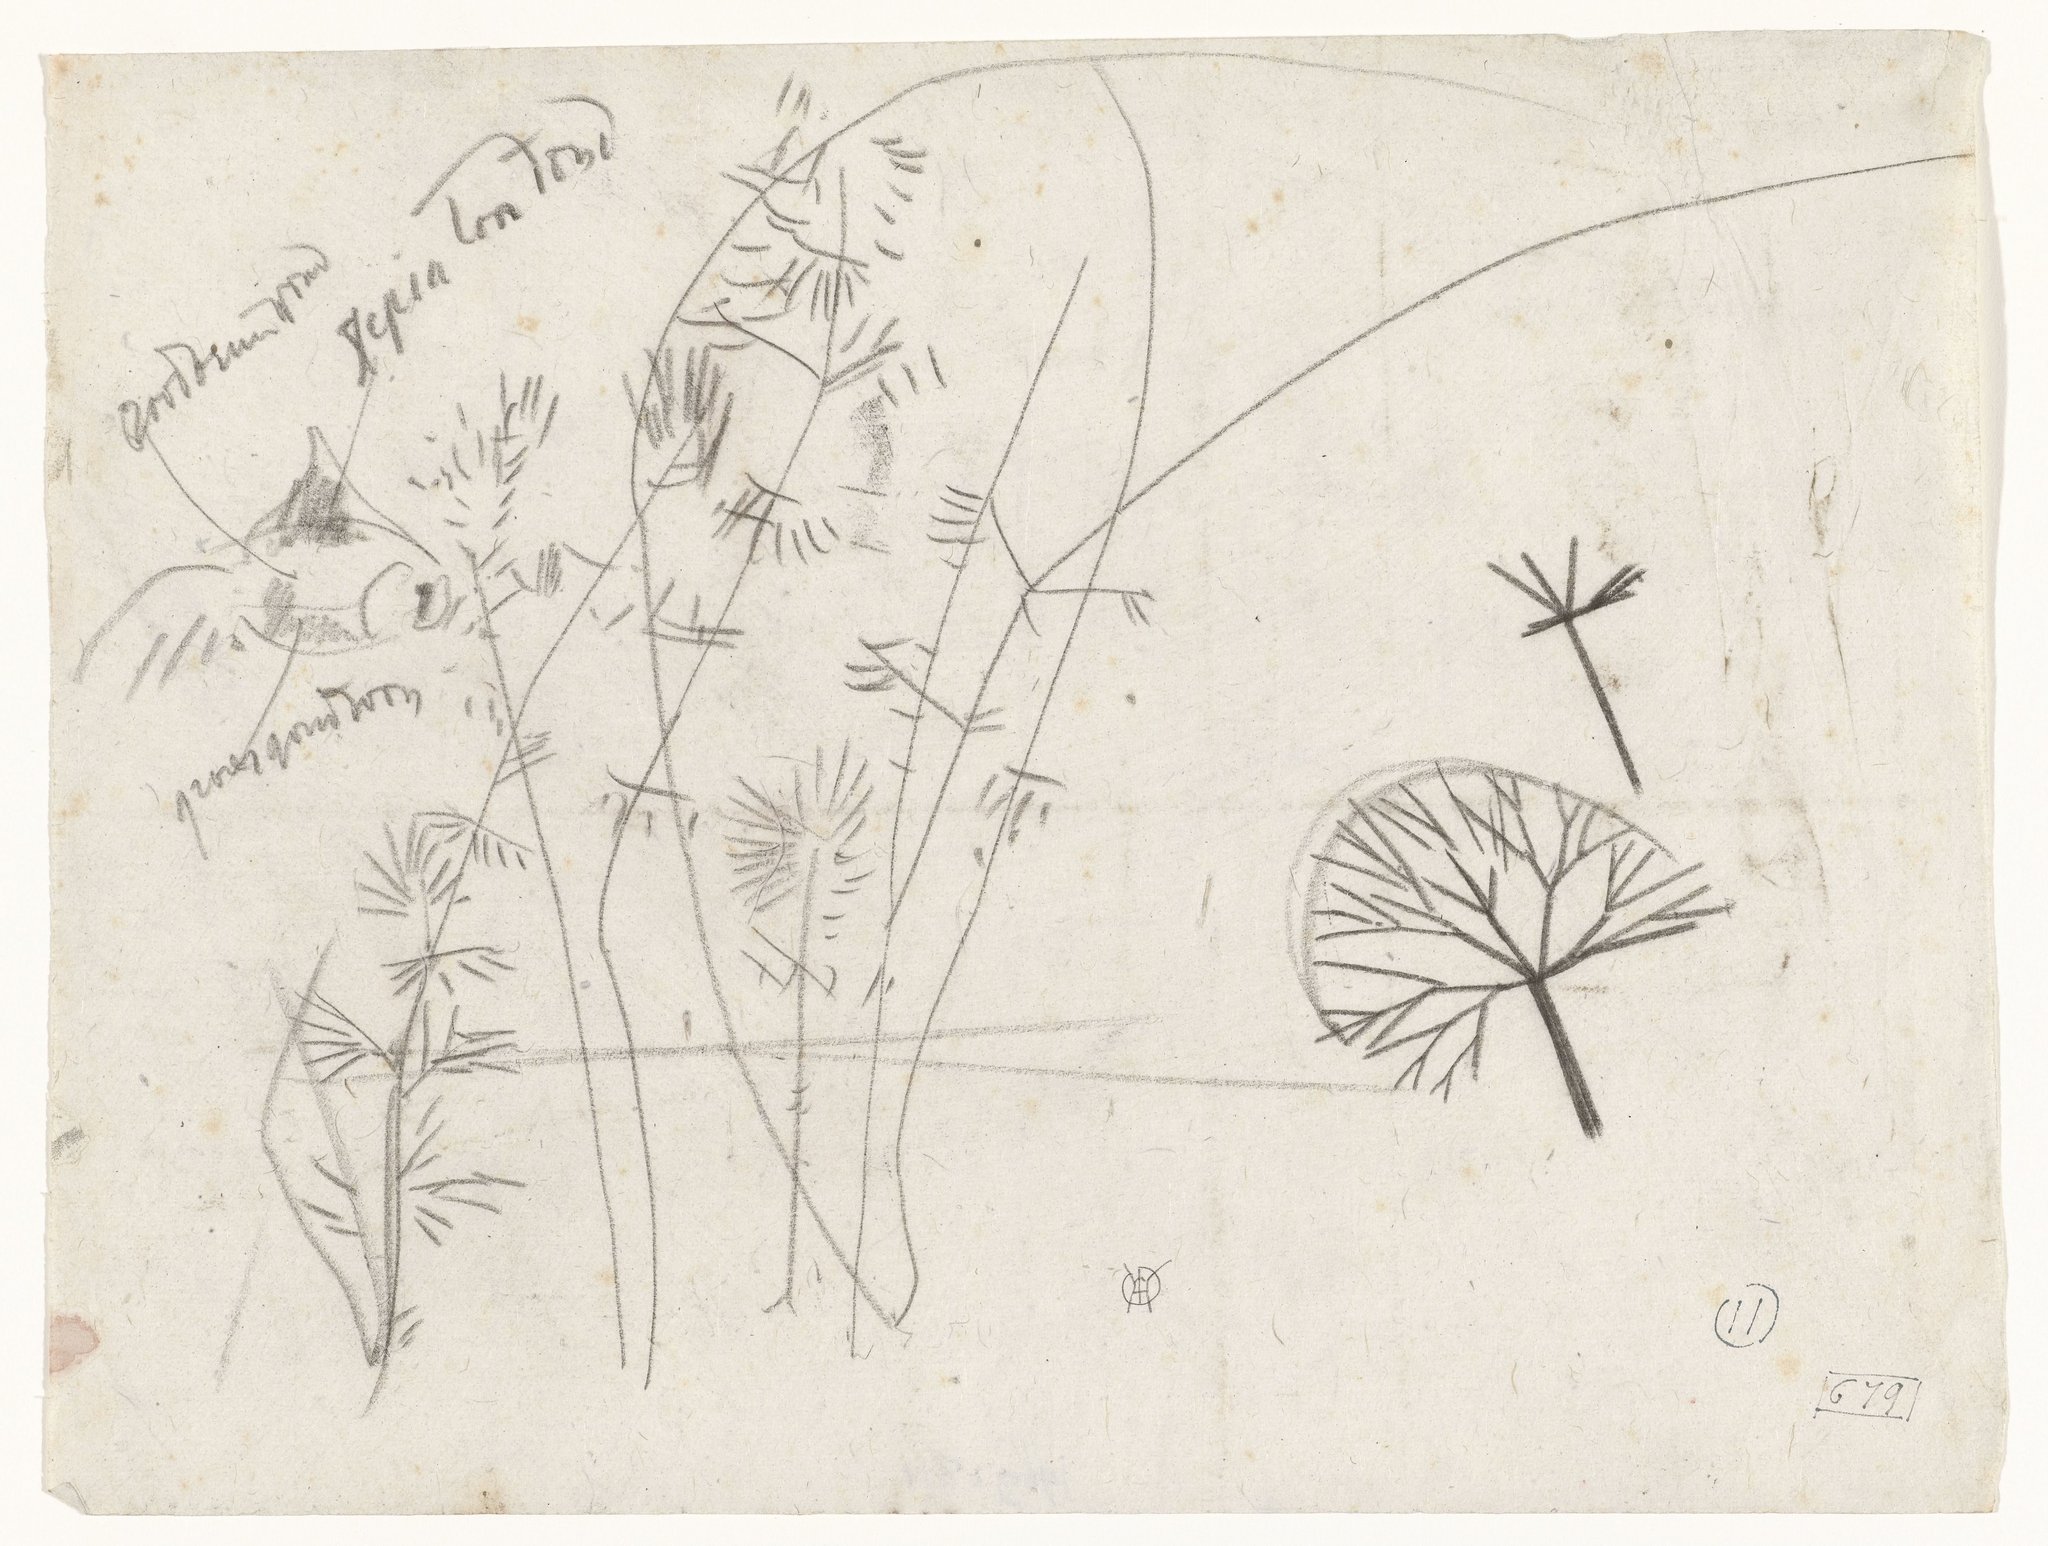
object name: drawing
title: Waterplanten met een vis, met kleurnotities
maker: gerrit willem dijsselhof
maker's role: designer, draughtsman, print maker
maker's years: 1866-1924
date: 1876-1924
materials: chalk, paper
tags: plants and herbs, bony fishes